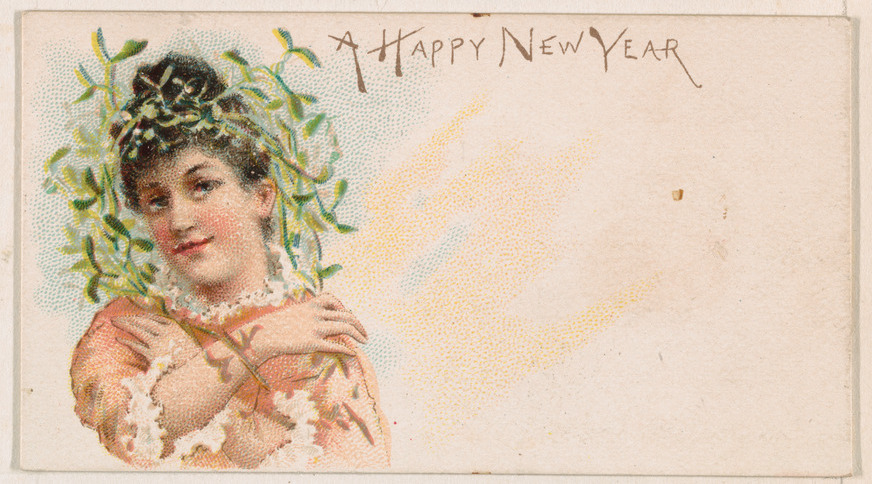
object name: print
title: A Happy New Year, from the New Years 1890 series (N227) issued by Kinney Bros.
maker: kinney brothers tobacco company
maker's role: publisher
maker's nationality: american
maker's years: 1869-2011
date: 1889-1890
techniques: color lithograph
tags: women